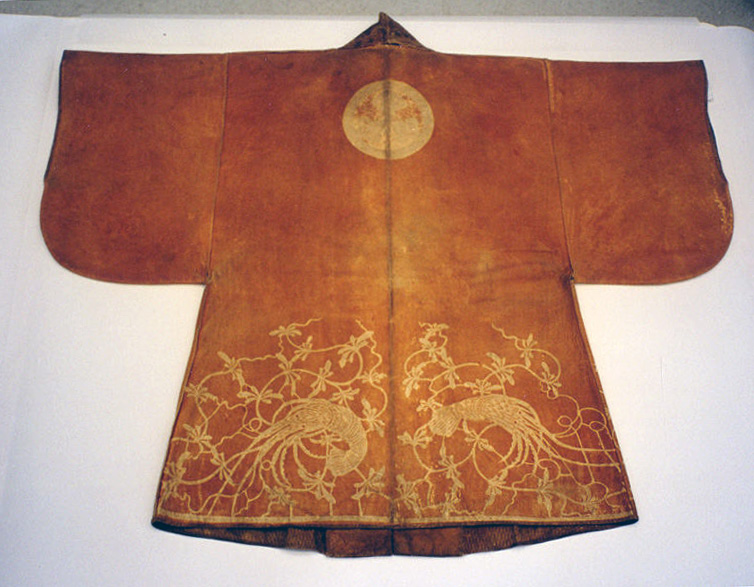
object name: leather coat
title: Leather Coat (Kawabaori) with Pattern of Large Shrimp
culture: japanese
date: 1801-1900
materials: leather, silk